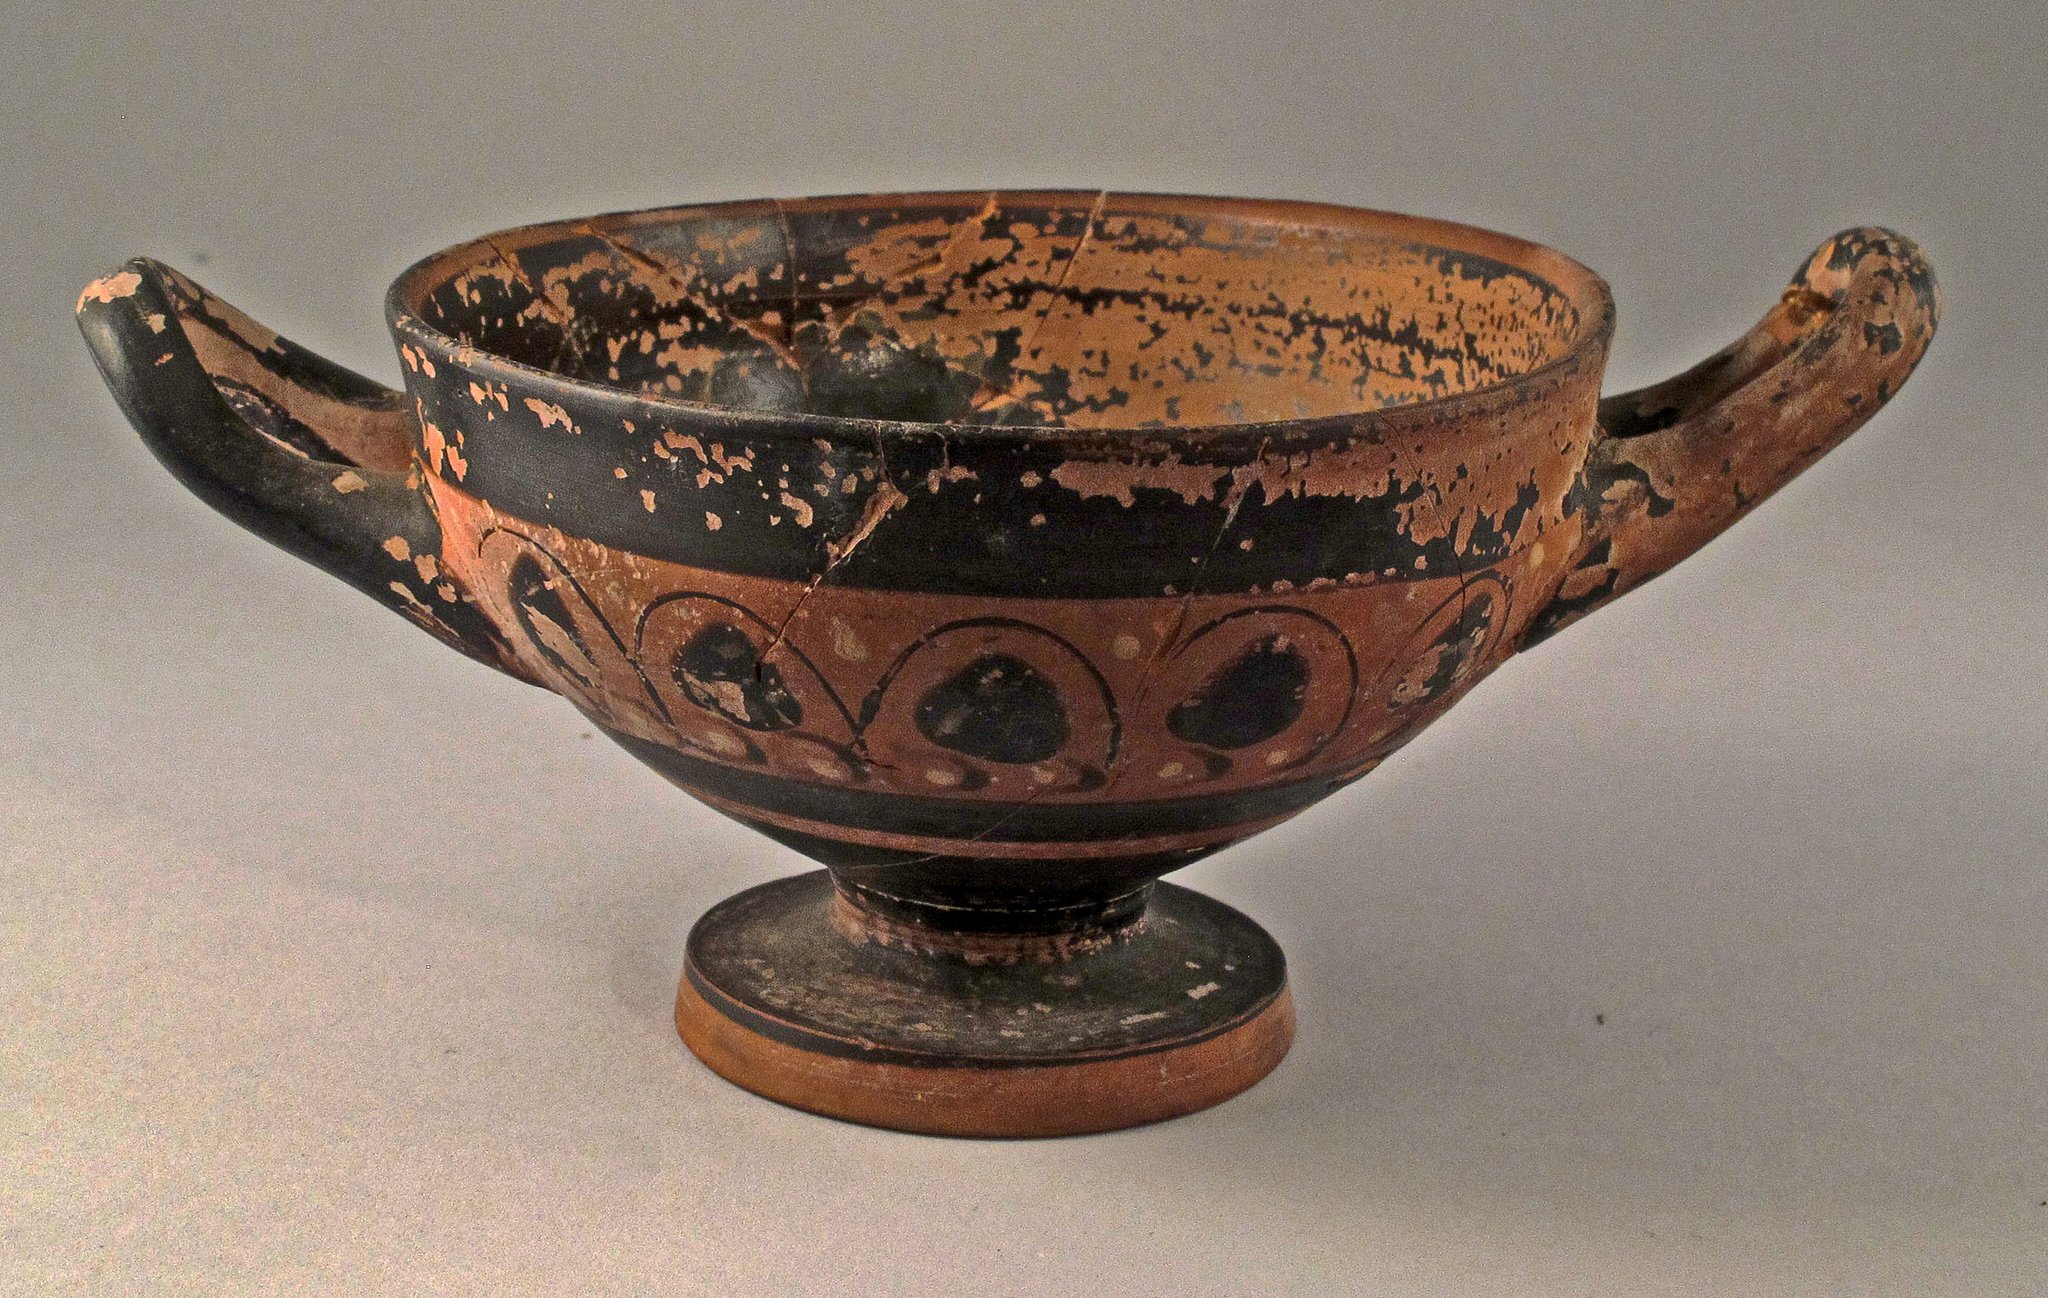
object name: skyphos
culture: greek, attic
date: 500 BCE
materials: terracotta